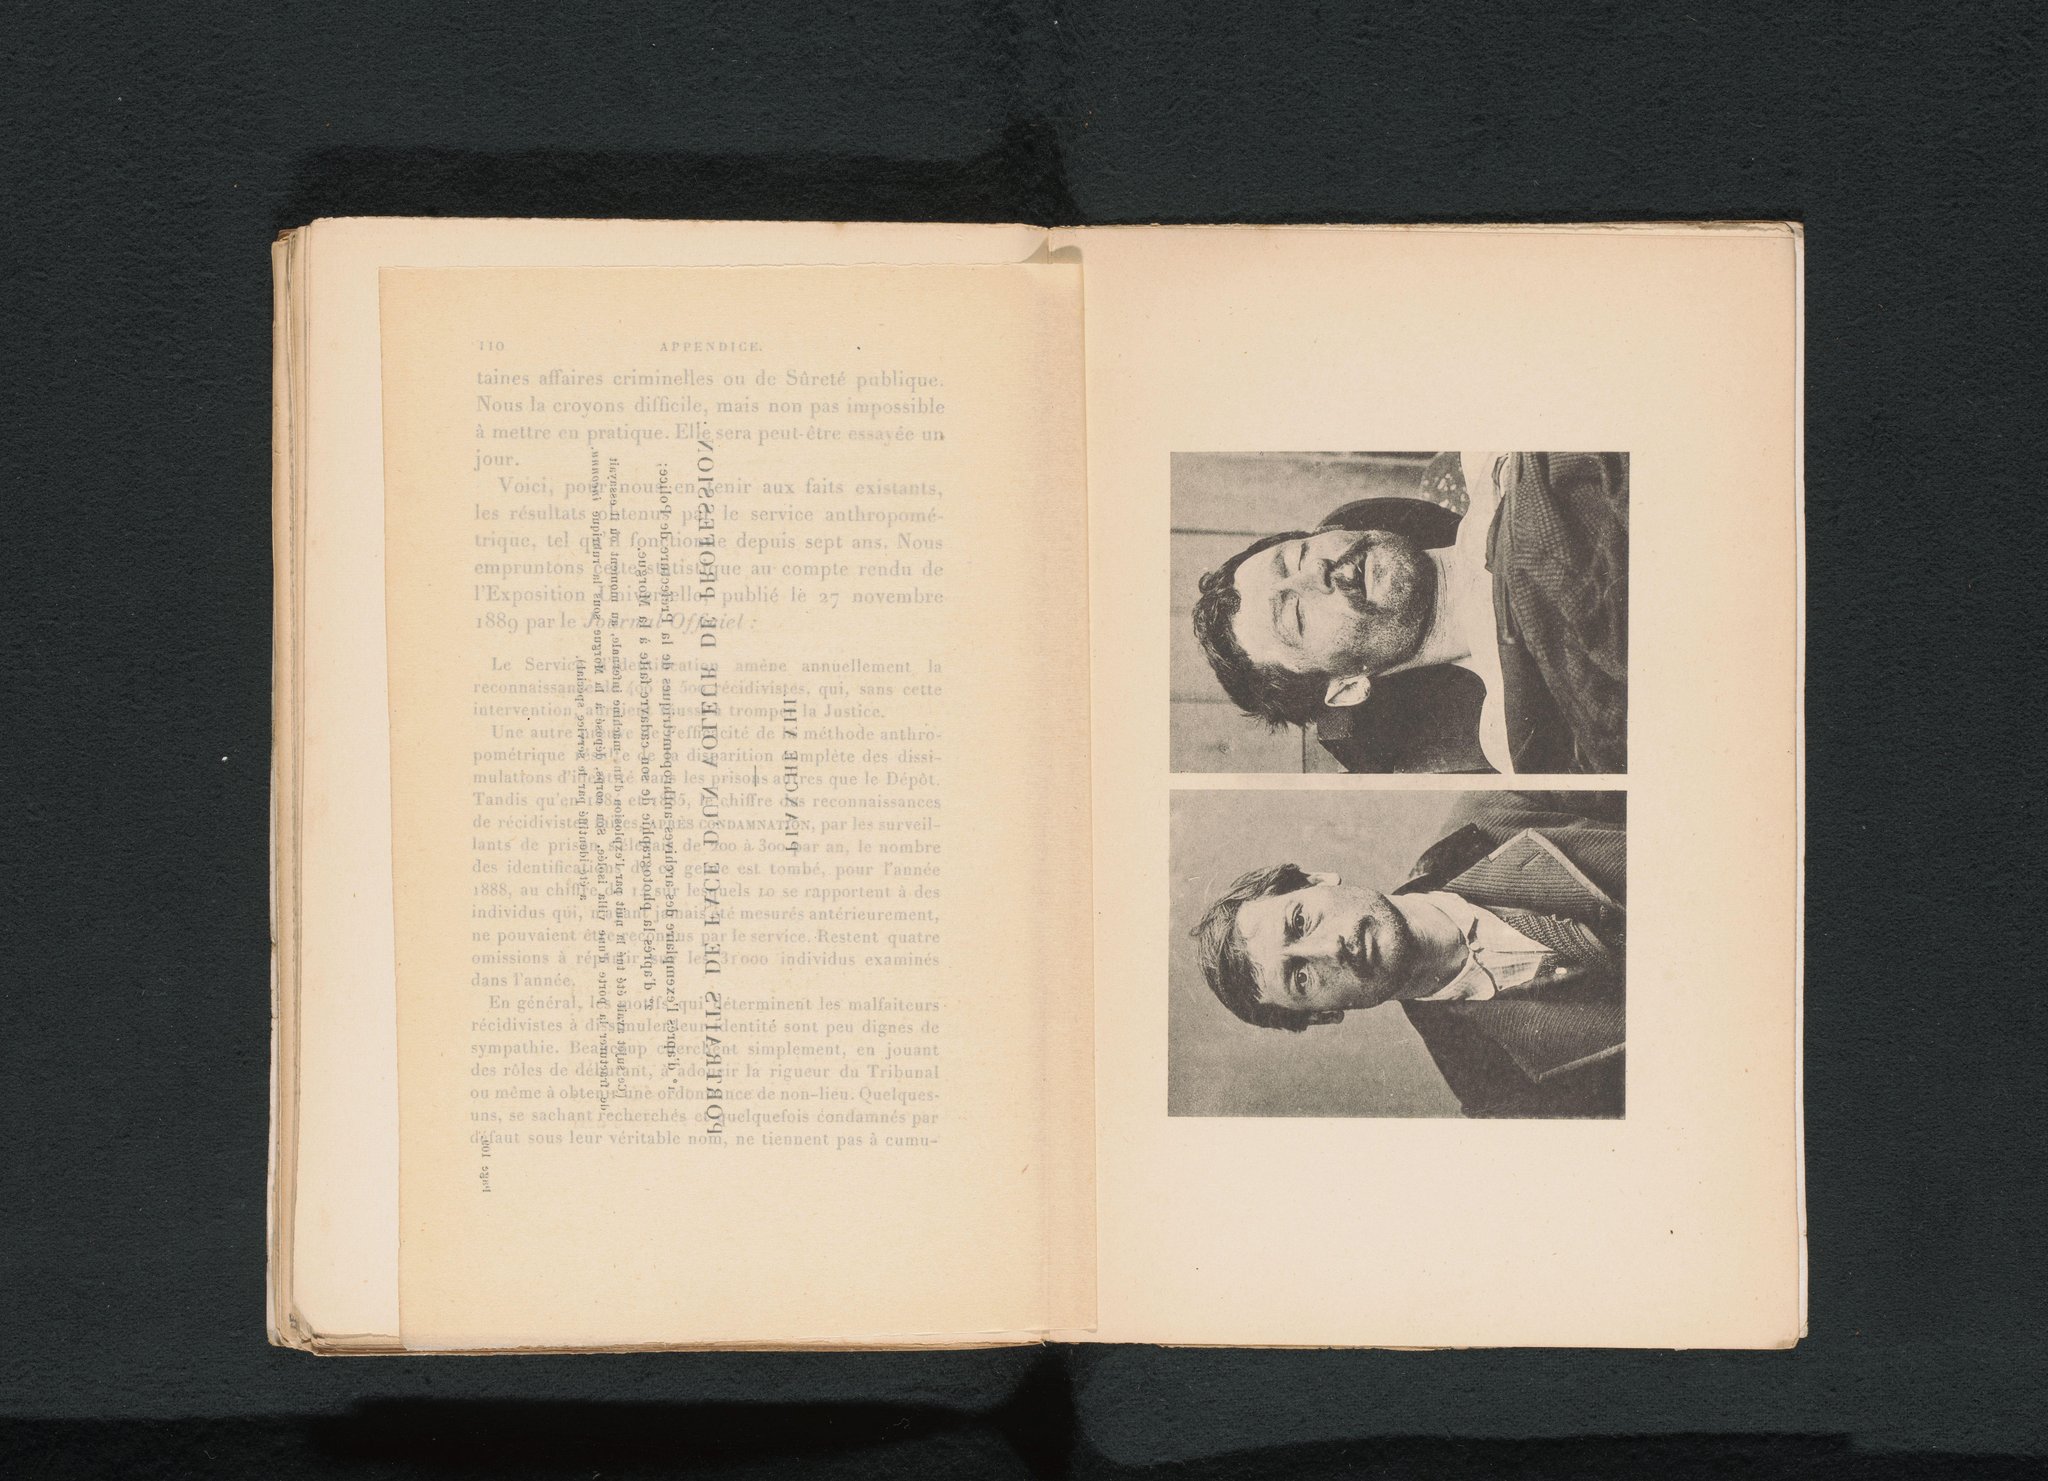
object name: photomechanical print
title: Twee gerechtelijke portretten van een onbekende man, na zijn arrestatie en na zijn dood in het mortuarium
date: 1885-1890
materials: paper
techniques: photograph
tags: historical persons, law and jurisprudence